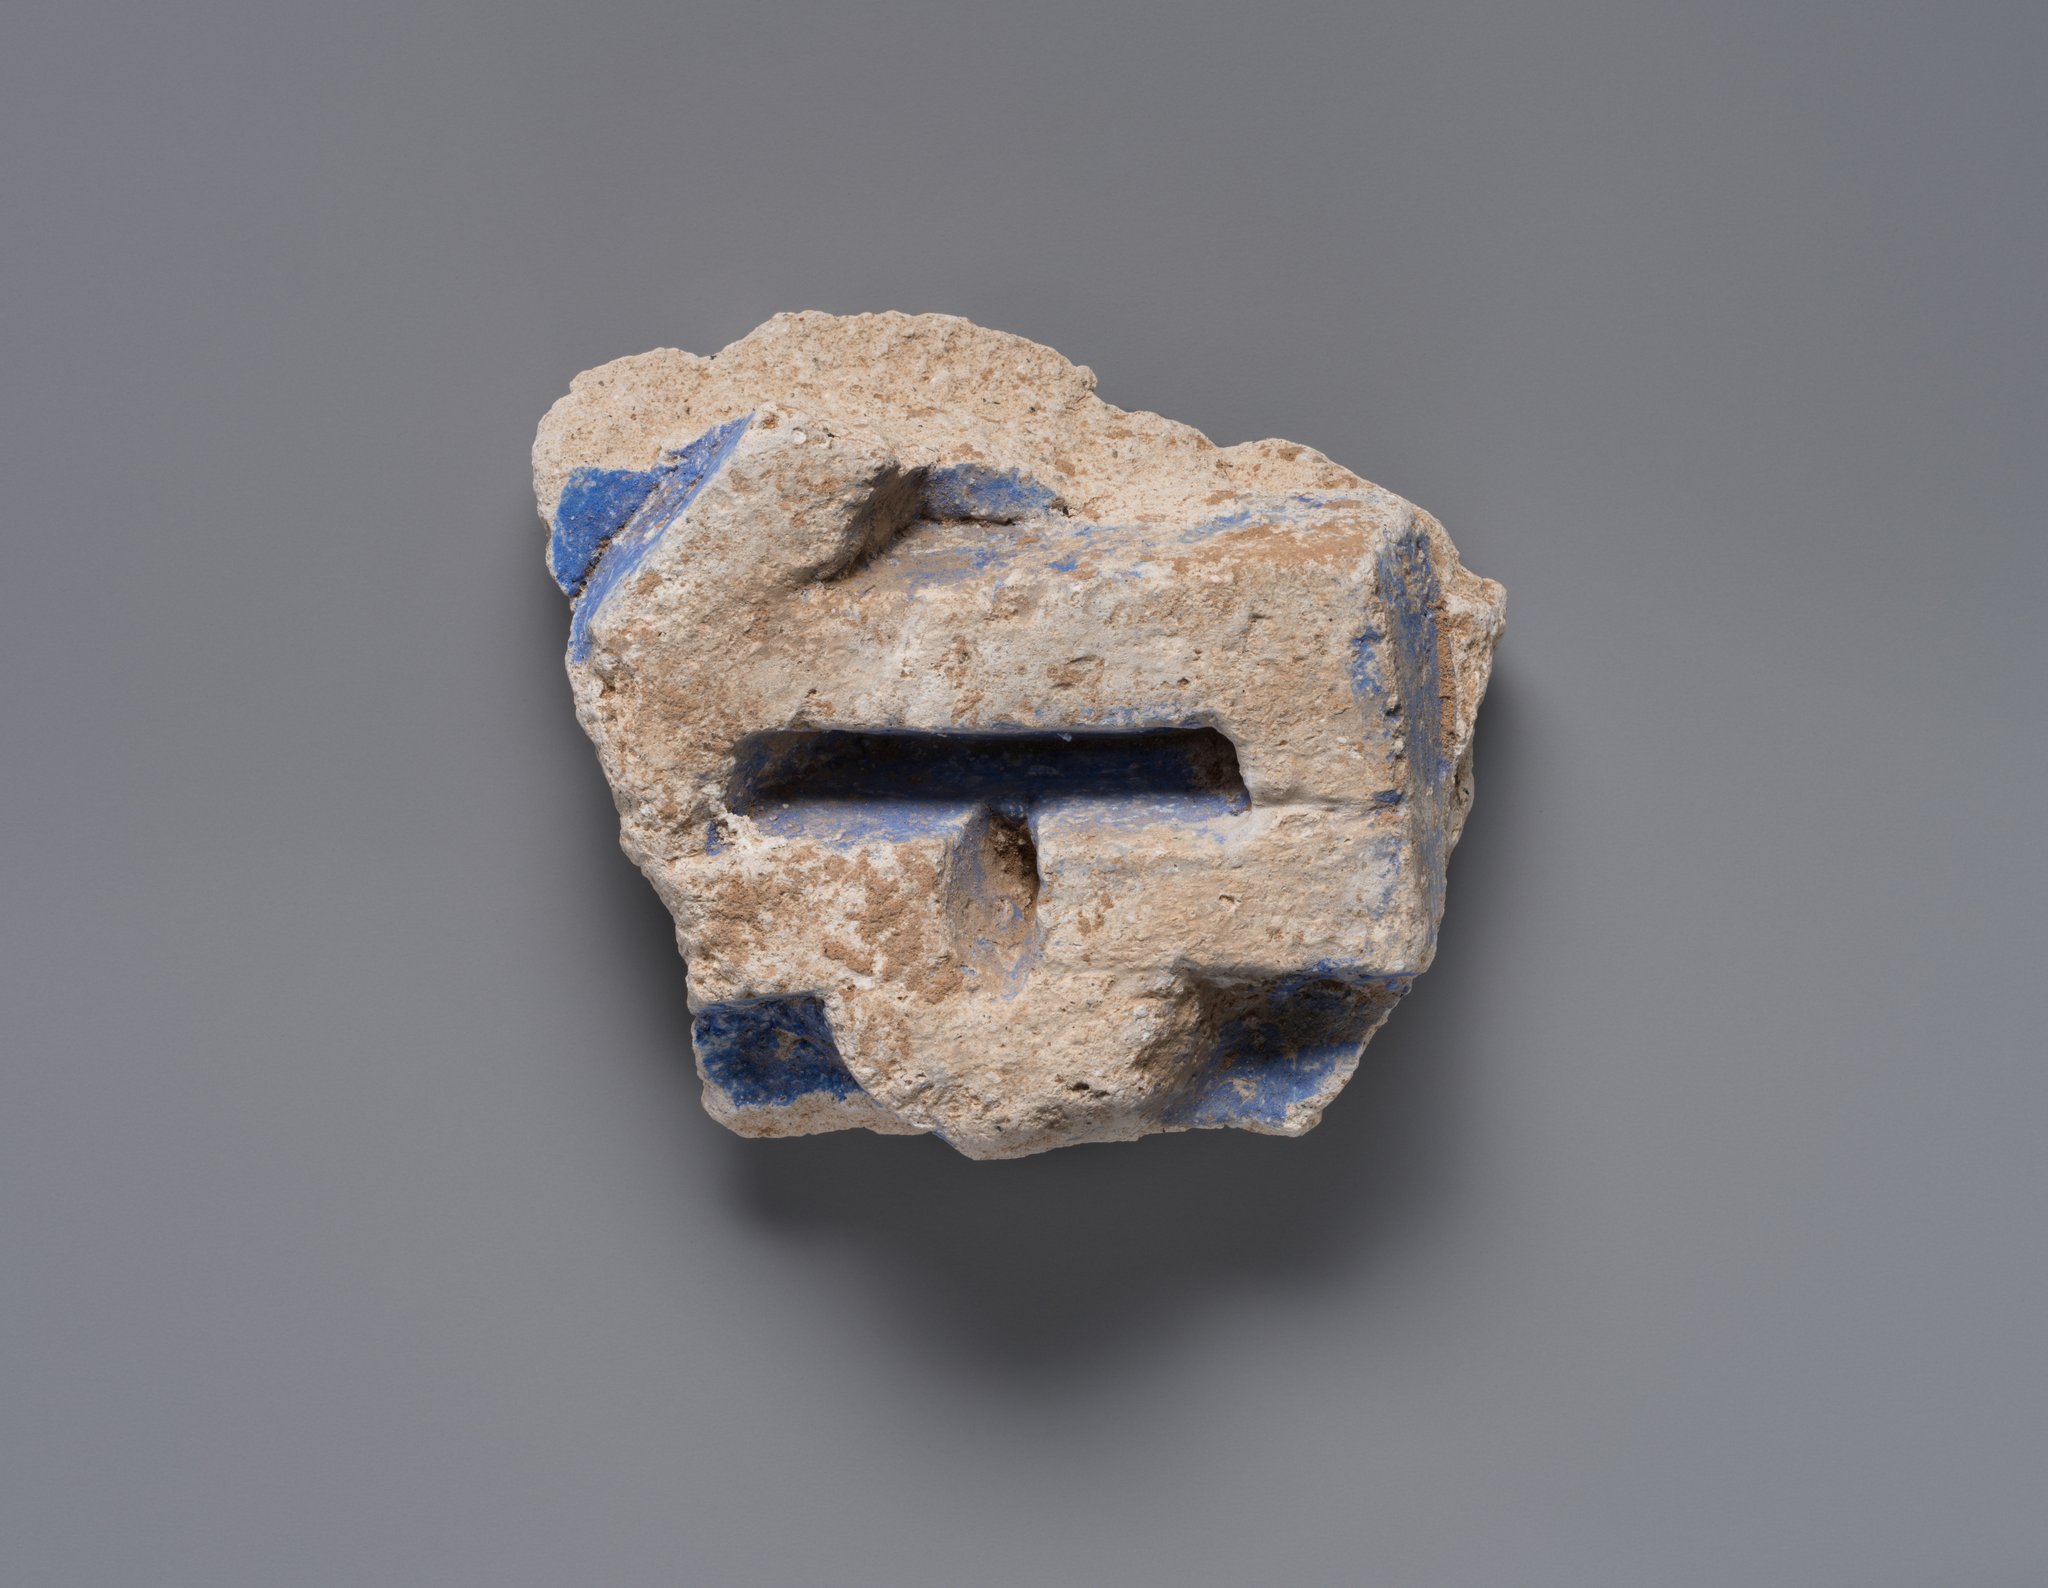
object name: fragment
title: Stucco Fragment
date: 701-1200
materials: plaster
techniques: carving, painting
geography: iran